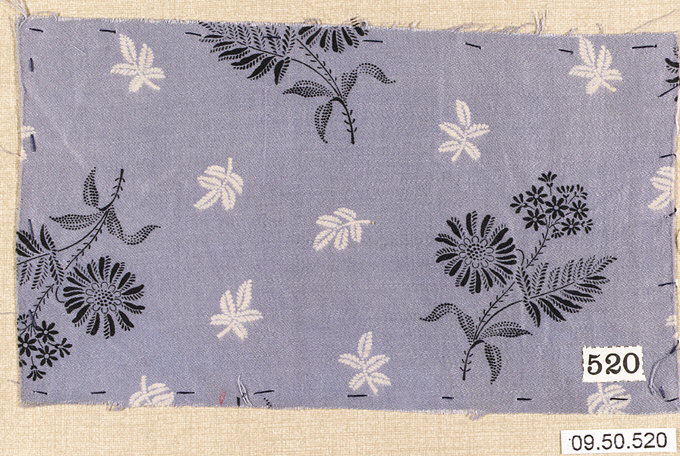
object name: piece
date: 1801-1900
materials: cotton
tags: flowers,leaves